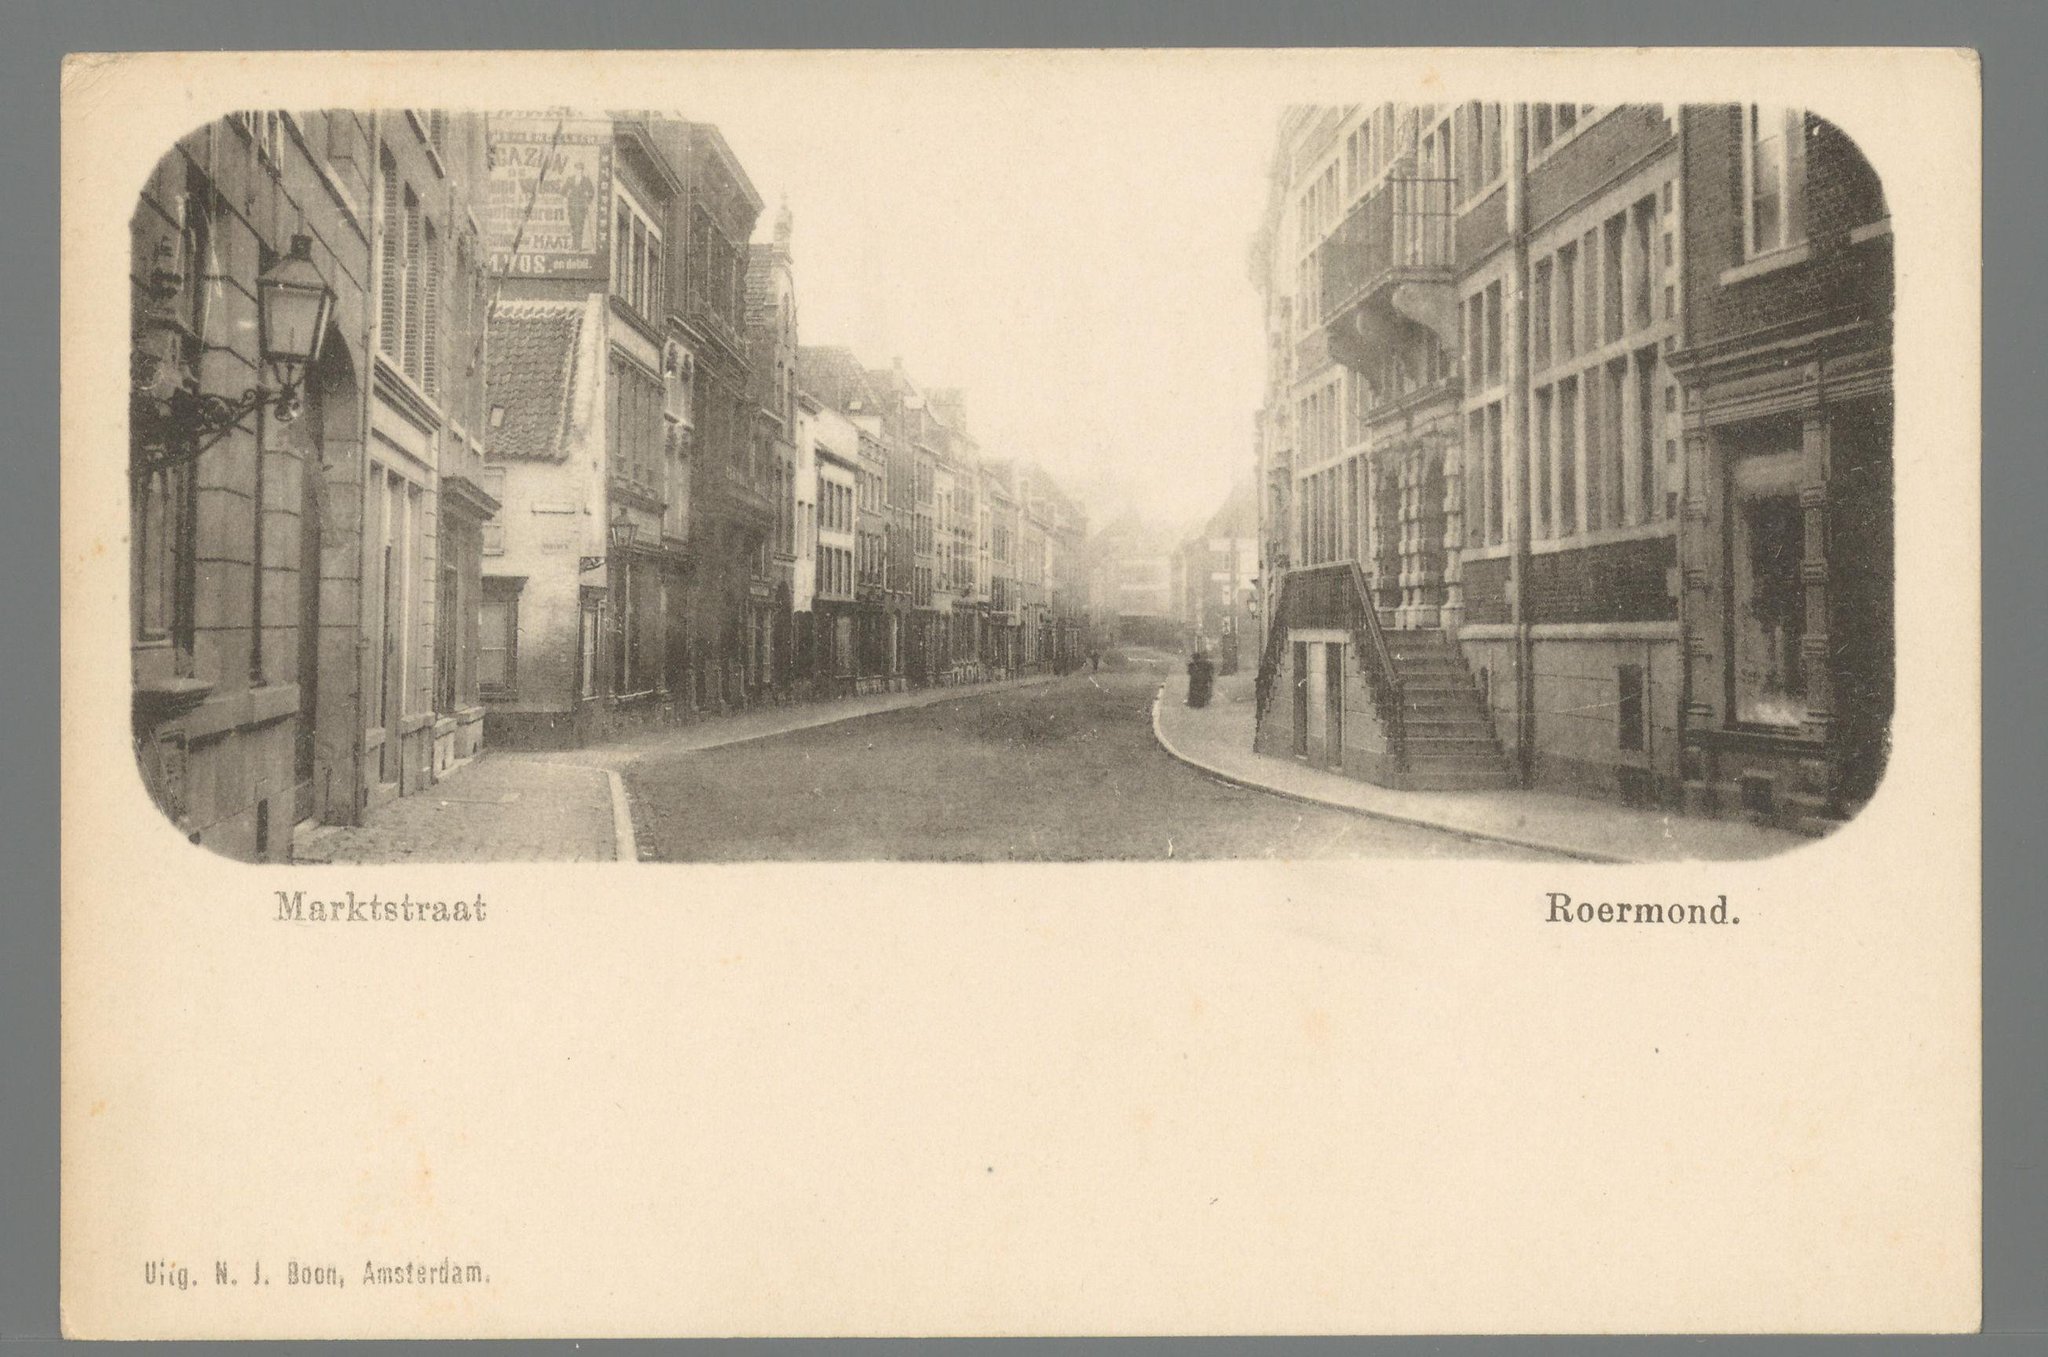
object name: ansichtkaart, prentbriefkaart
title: Marktstraat. Roermond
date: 1895-1901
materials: cardboard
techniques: photograph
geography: roermond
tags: street, roermond